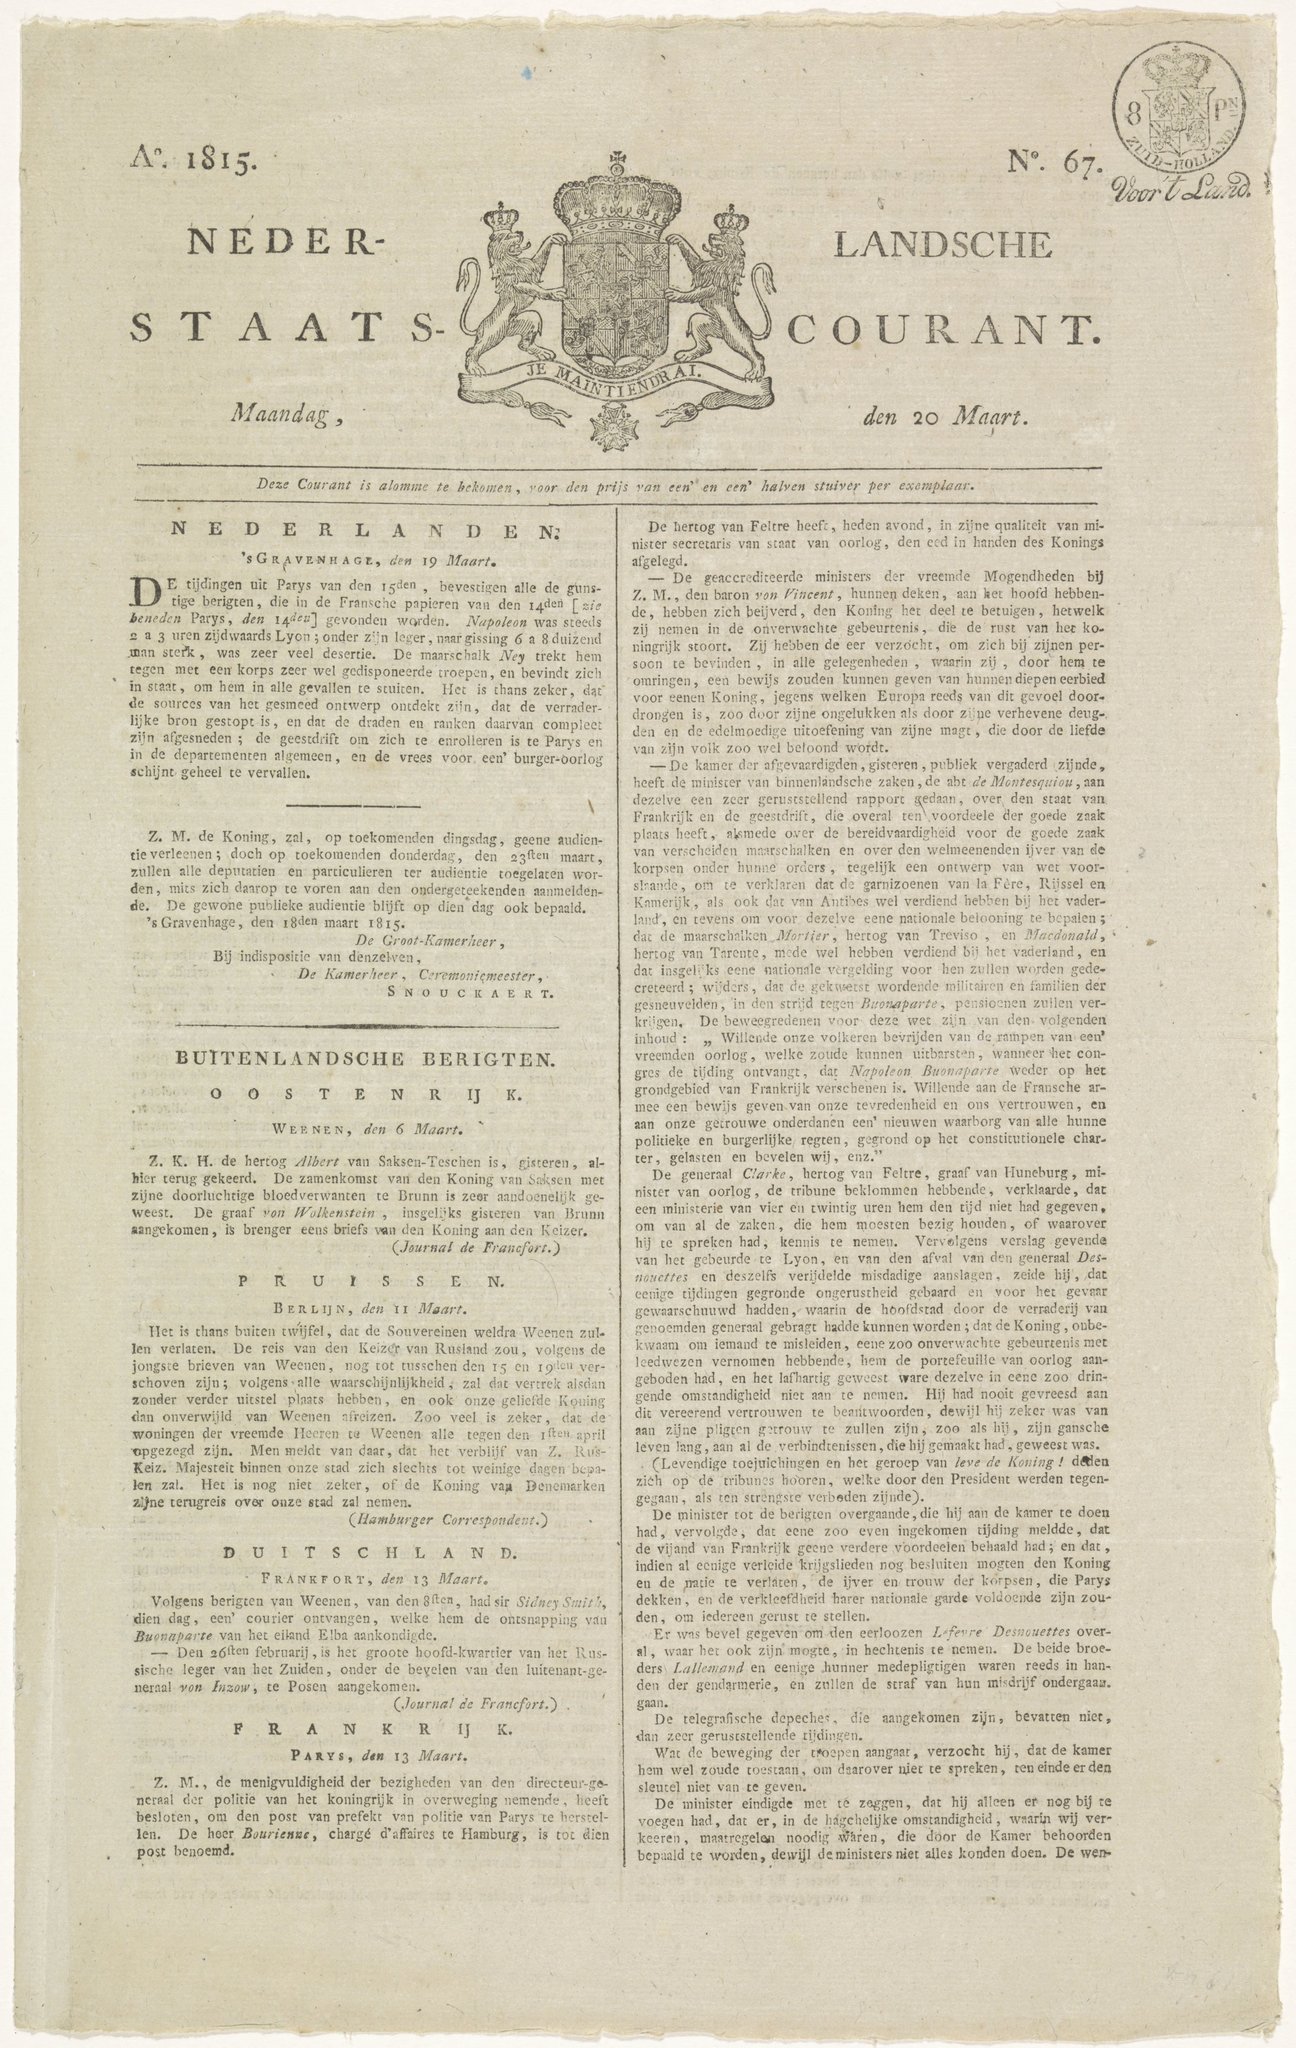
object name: newspaper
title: Nederlandsche Staatscourant. Ao. 1815 No. 67. Maandag, den 20 Maart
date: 1815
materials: paper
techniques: letterpress printing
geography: the hague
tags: the hague, berlin, william i of the netherlands, napoleon i (emperor of the french)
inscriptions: collector's mark: Lugt 2228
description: Aflevering van de Nederlandsche Staatscourant van 20 maart 1815, met het nieuws van de proclamatie op 16 maart van de soevereine vorst Willem I als Koning der Nederlanden en Hertog van Luxemburg, en het nieuws van het oprukken van Napoleon door Frankrijk. Dubbelgevouwen blad bedrukt op alle vier zijden.